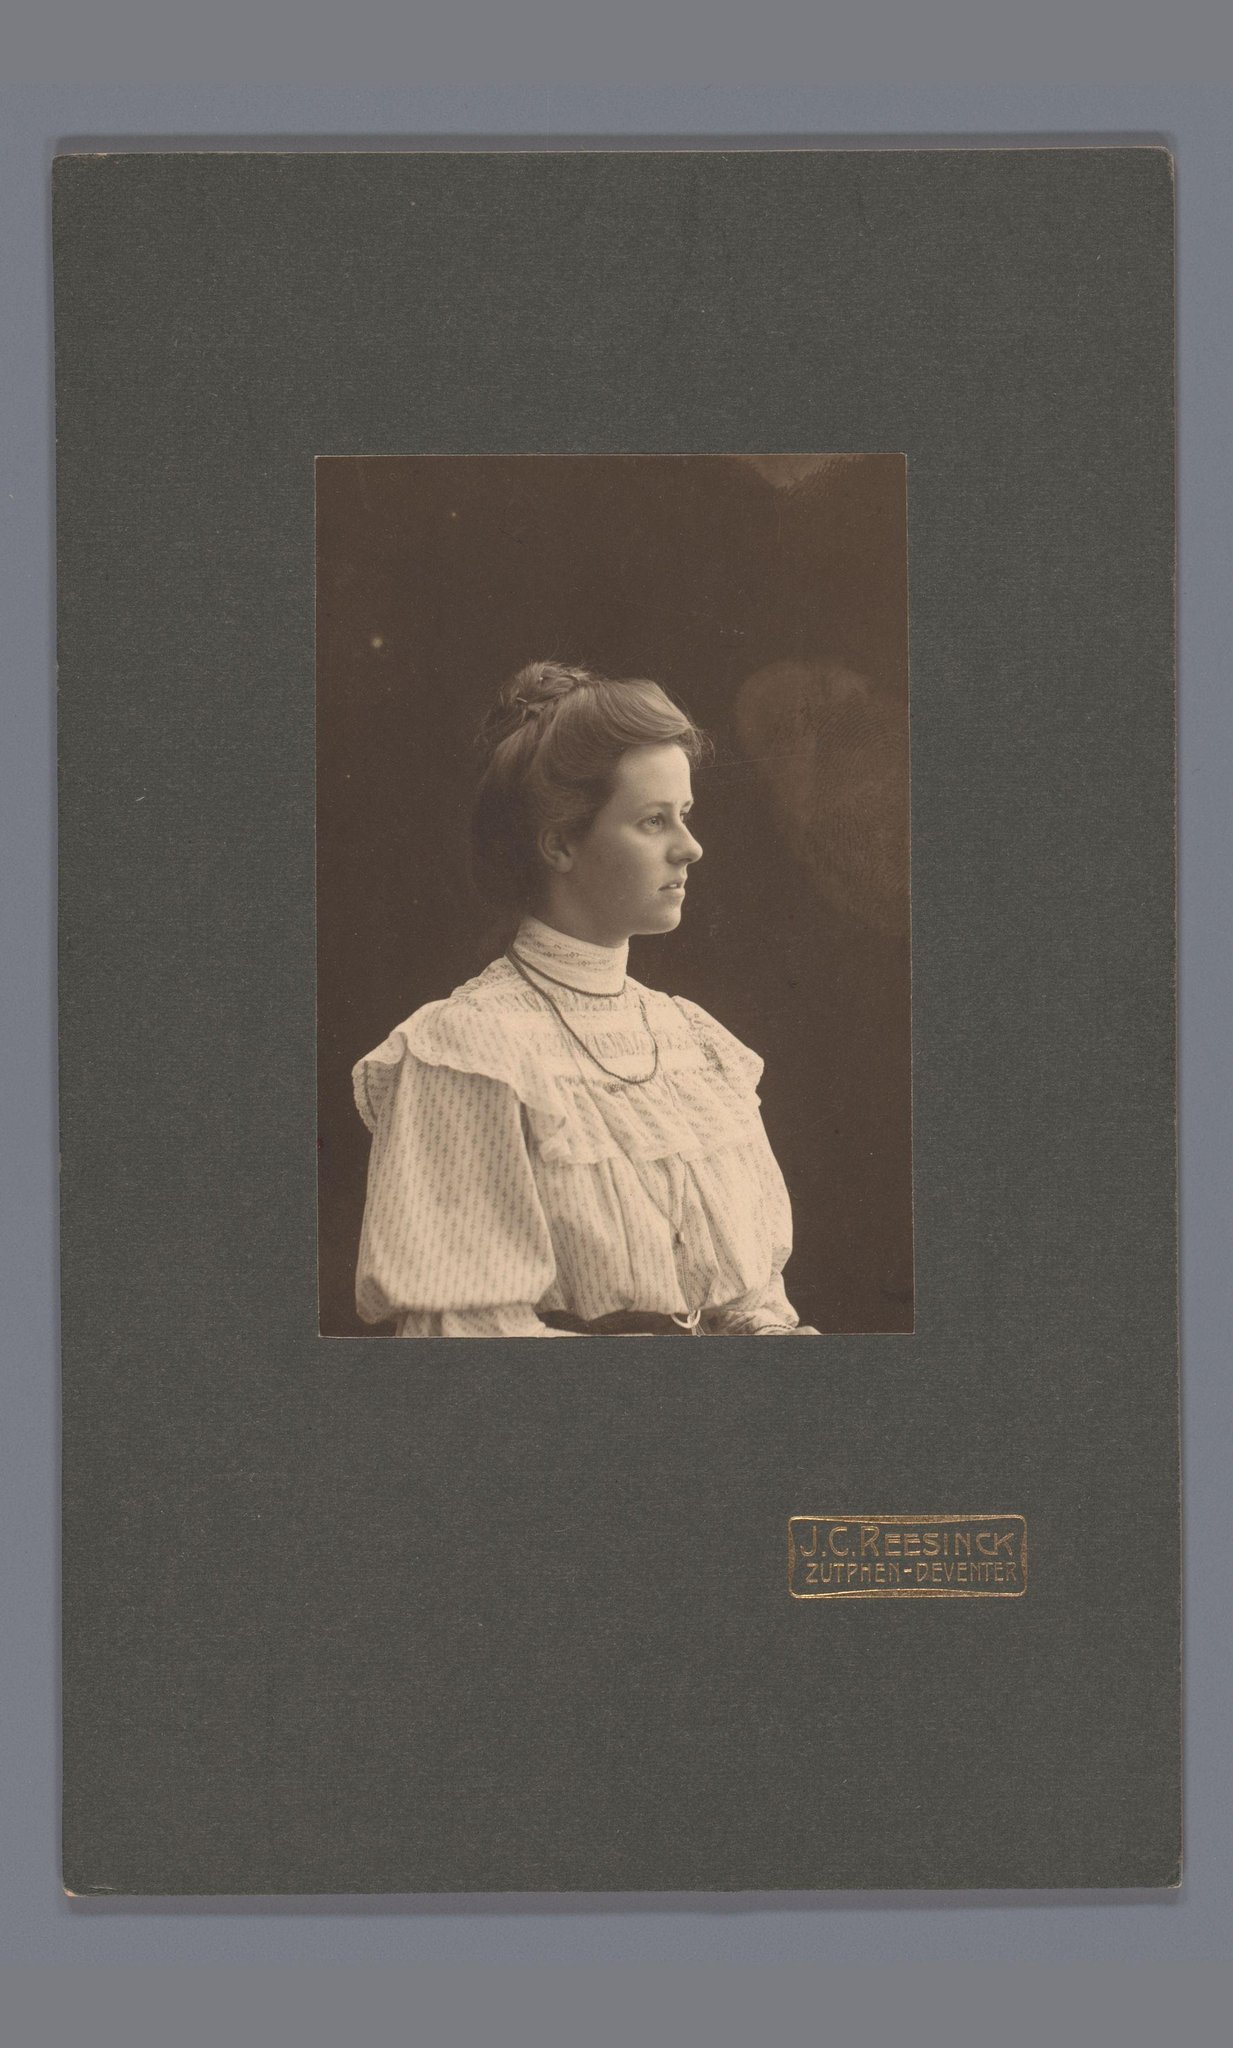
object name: cabinet photograph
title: Portret van Johanna Geertruida Jonker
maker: johan christiaan reesinck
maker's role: fotograaf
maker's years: 1838-1922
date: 1900-1907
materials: cardboard, photographic support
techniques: gelatin silver print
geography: zutphen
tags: historical persons